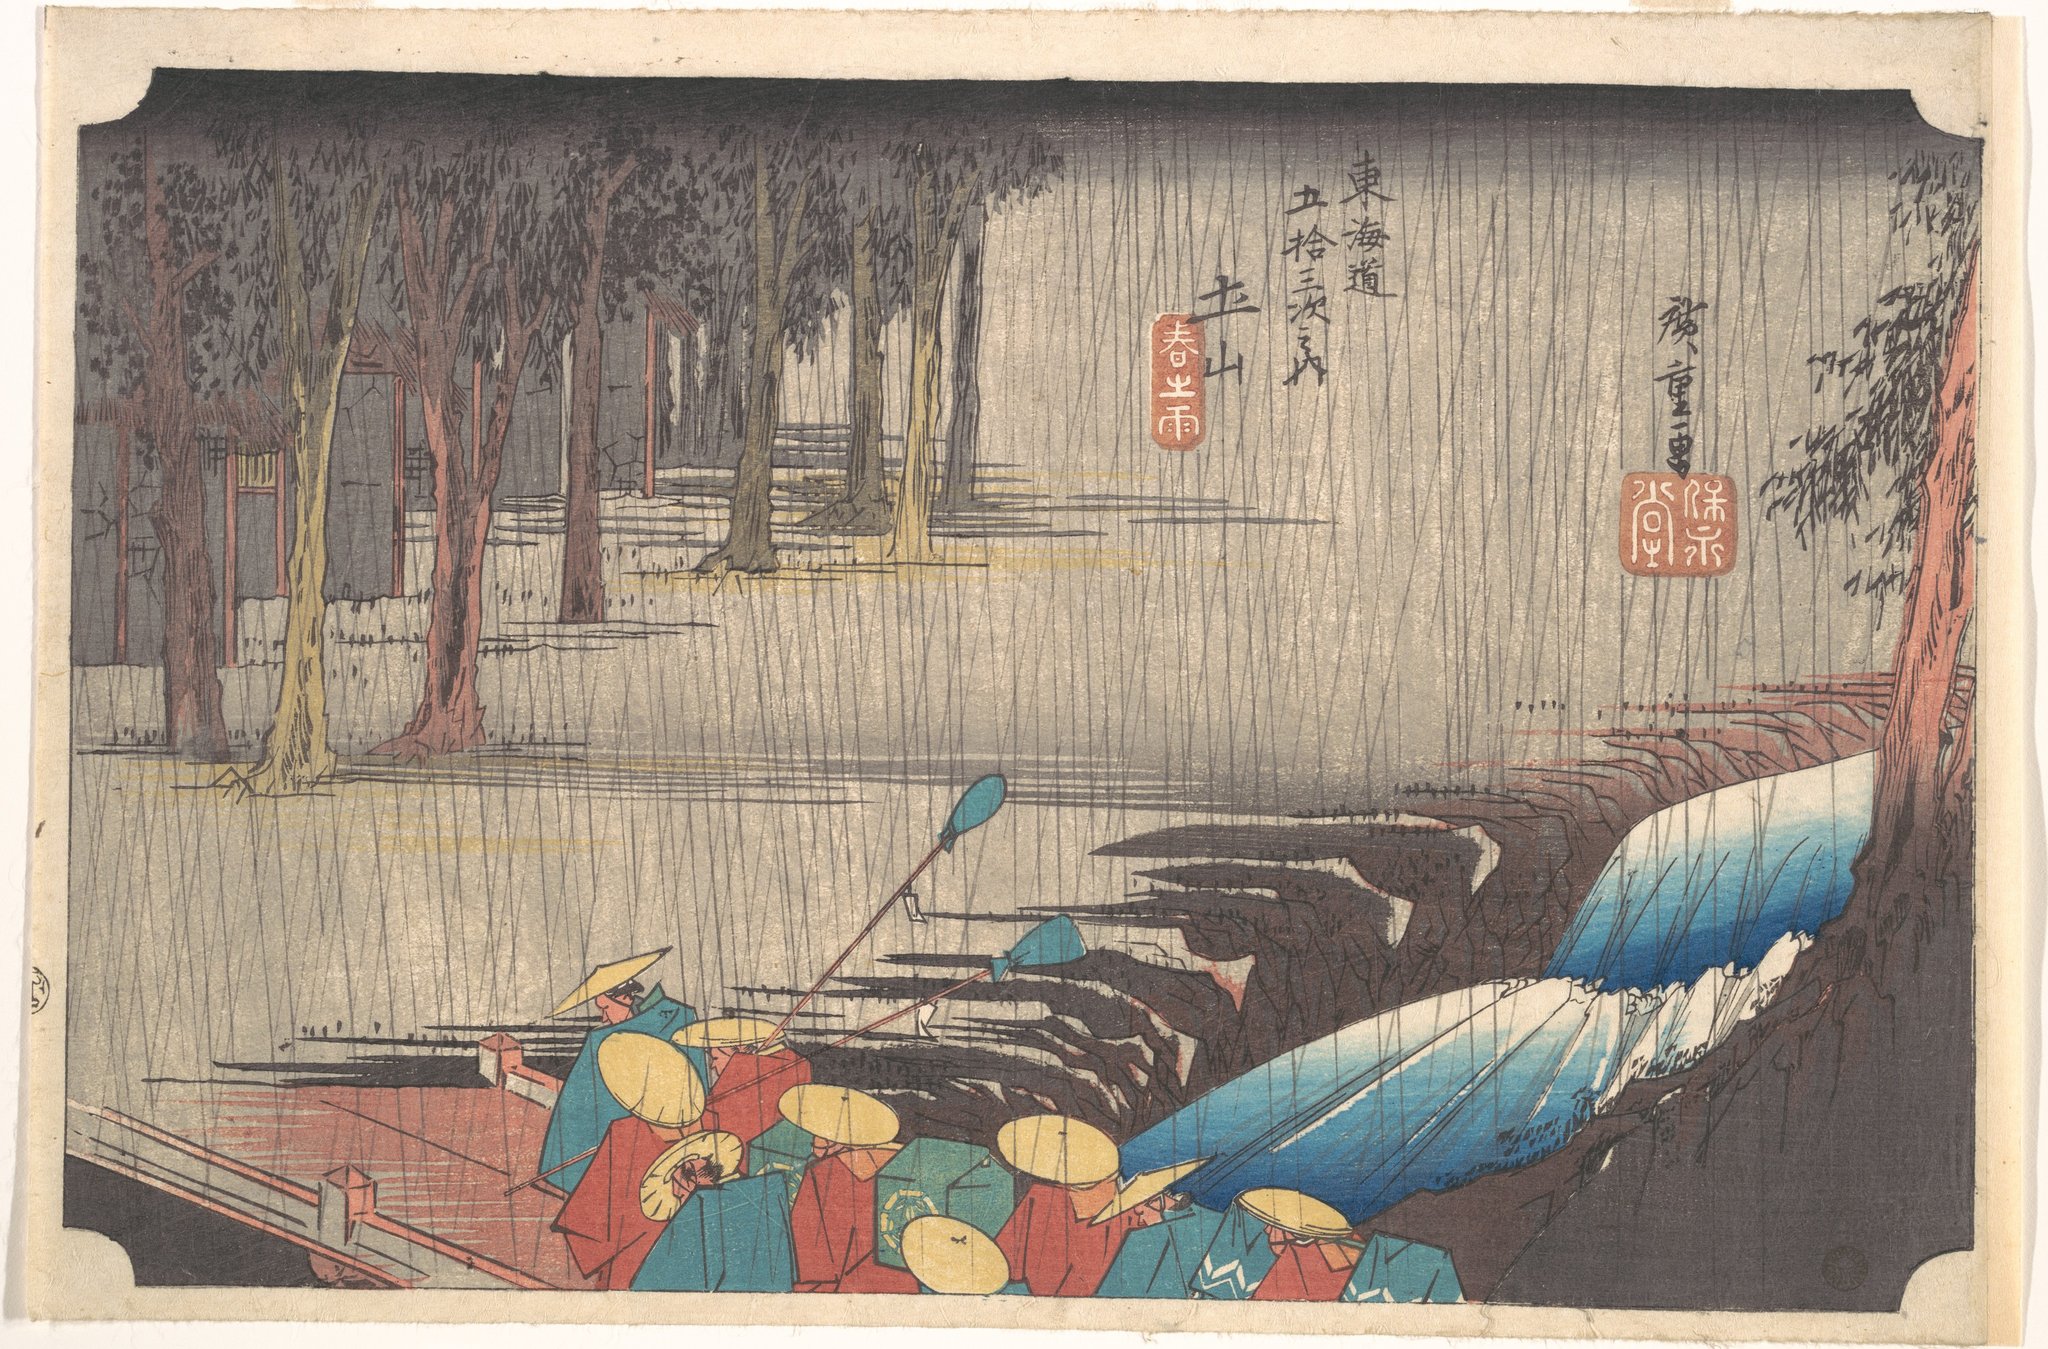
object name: print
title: Spring Rain at Tsuchiyama, from the series Fifty-three Stations of the Tōkaidō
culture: japanese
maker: utagawa hiroshige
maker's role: artist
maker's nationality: japanese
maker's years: 1797-1858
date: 1834-1835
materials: ink, paper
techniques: woodblock print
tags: human figures,bridges,hats,trees,rain